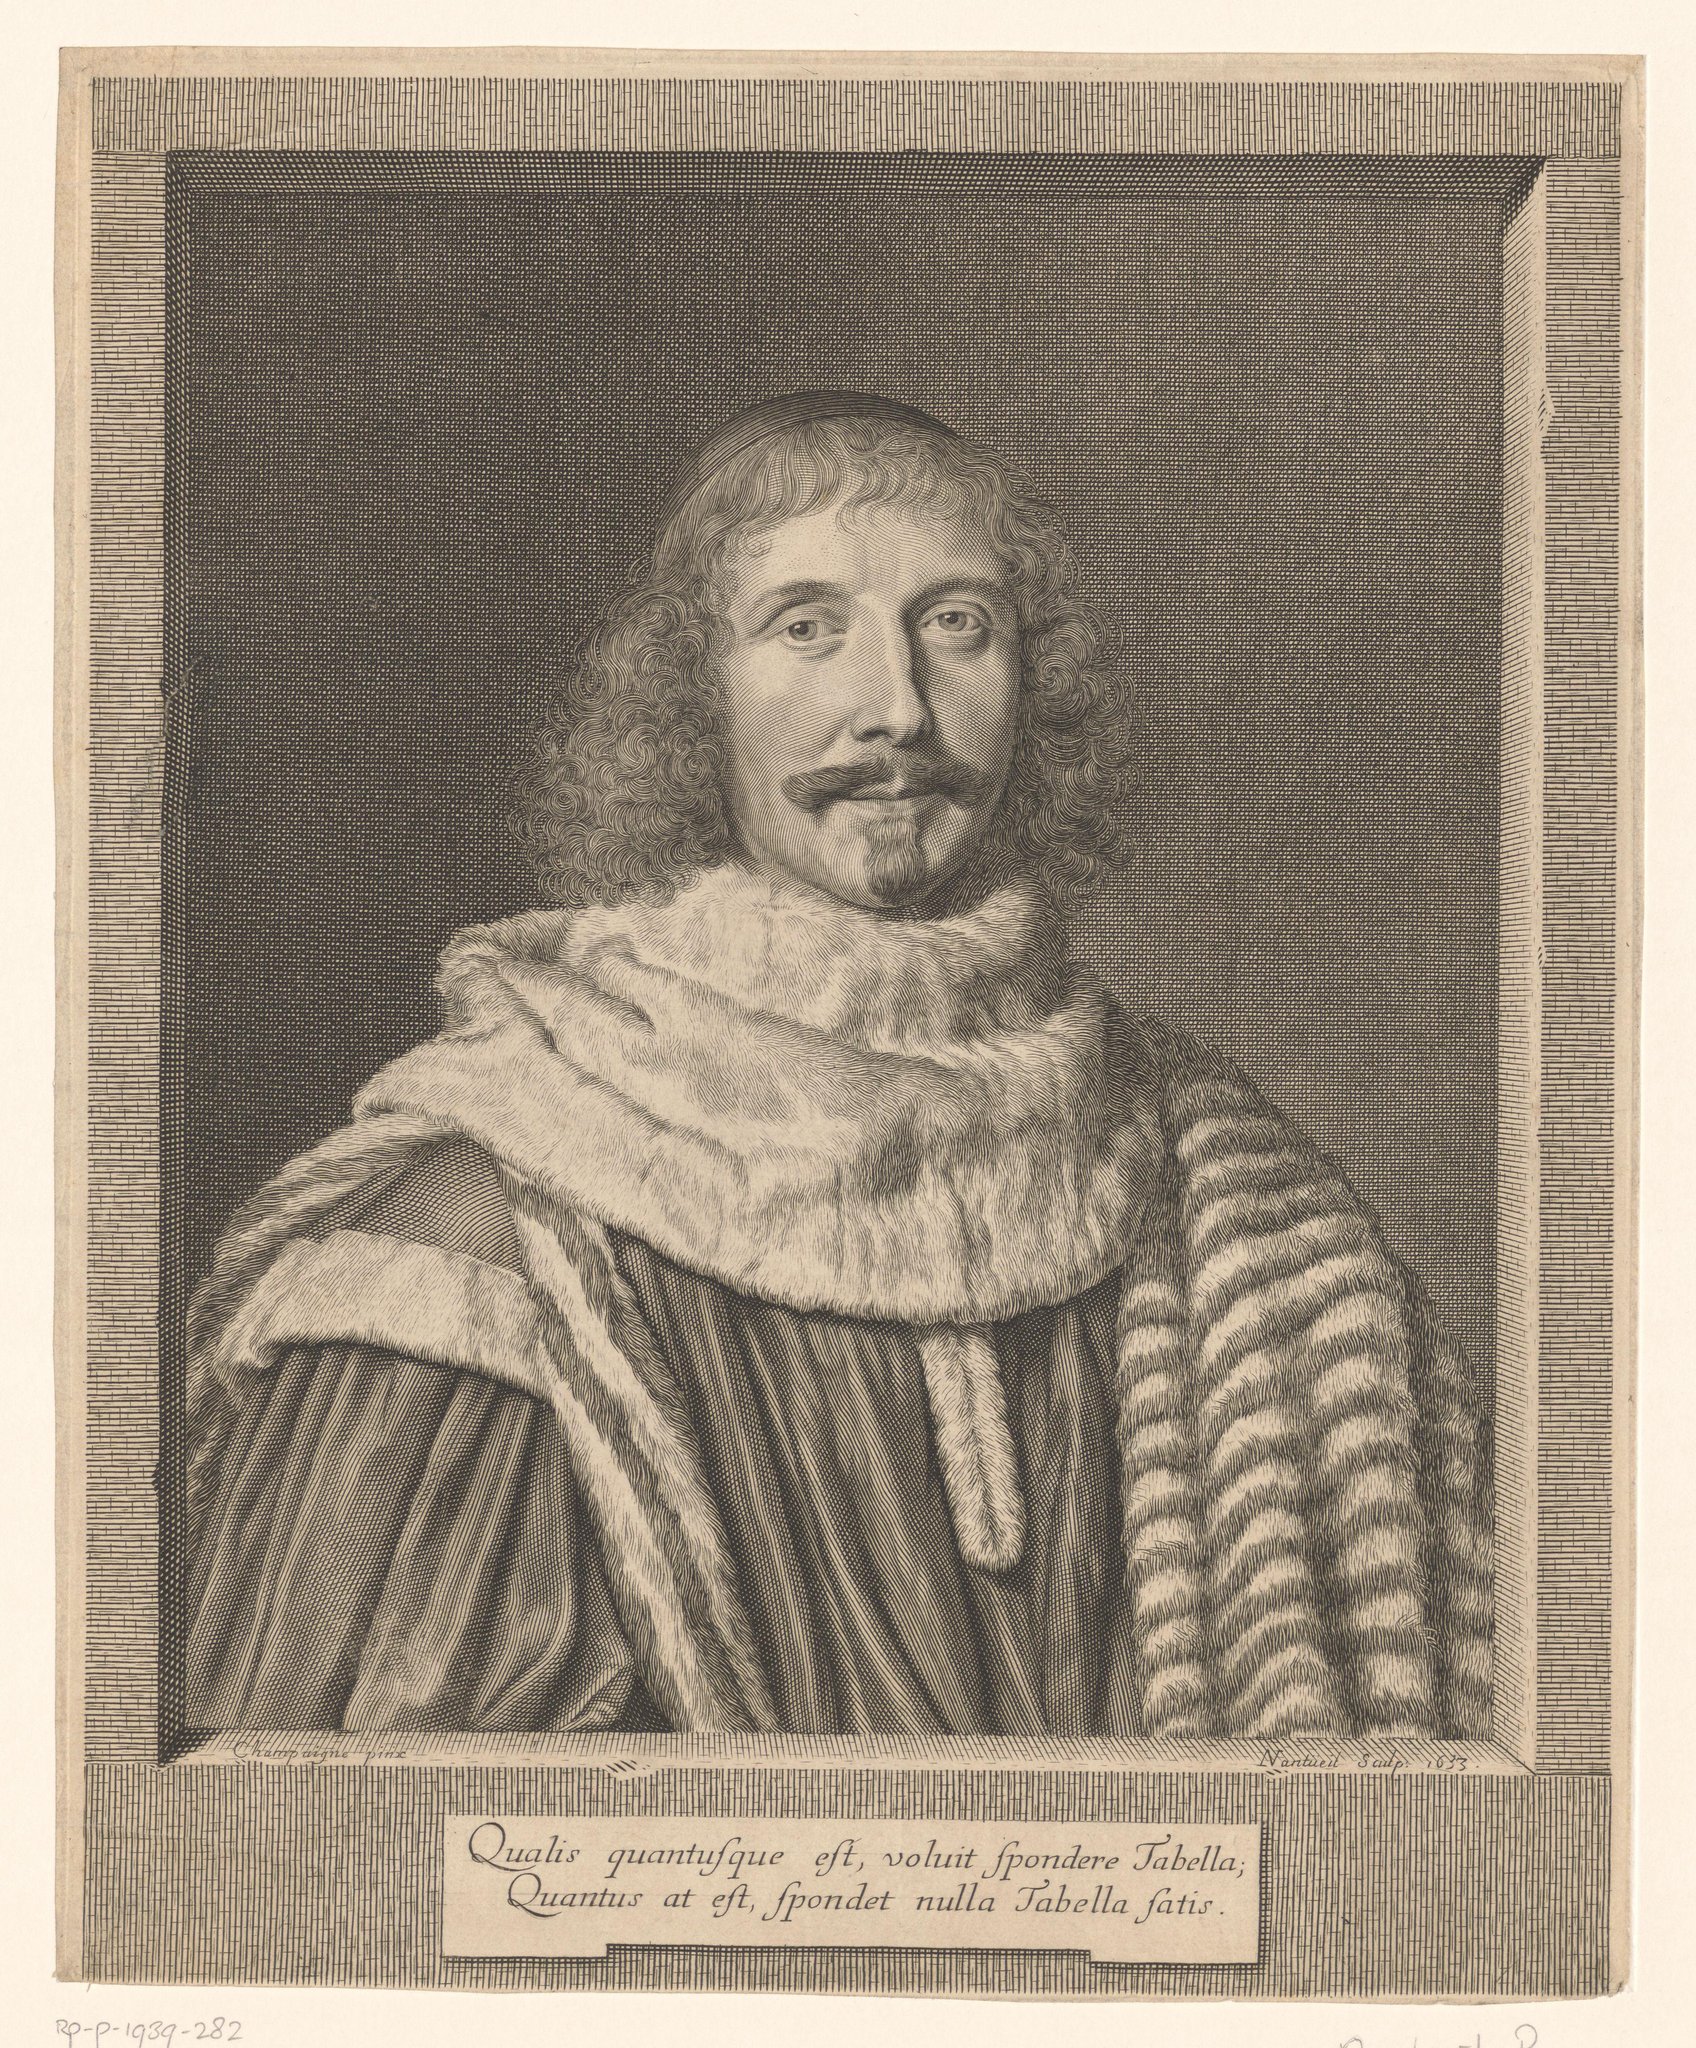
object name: print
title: Portret van Pompone II de Bellièvre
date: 1653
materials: paper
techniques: engraving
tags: historical persons, politician, e.g. party leader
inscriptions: collector's mark: Lugt 2228, collector's mark: Lugt 2760